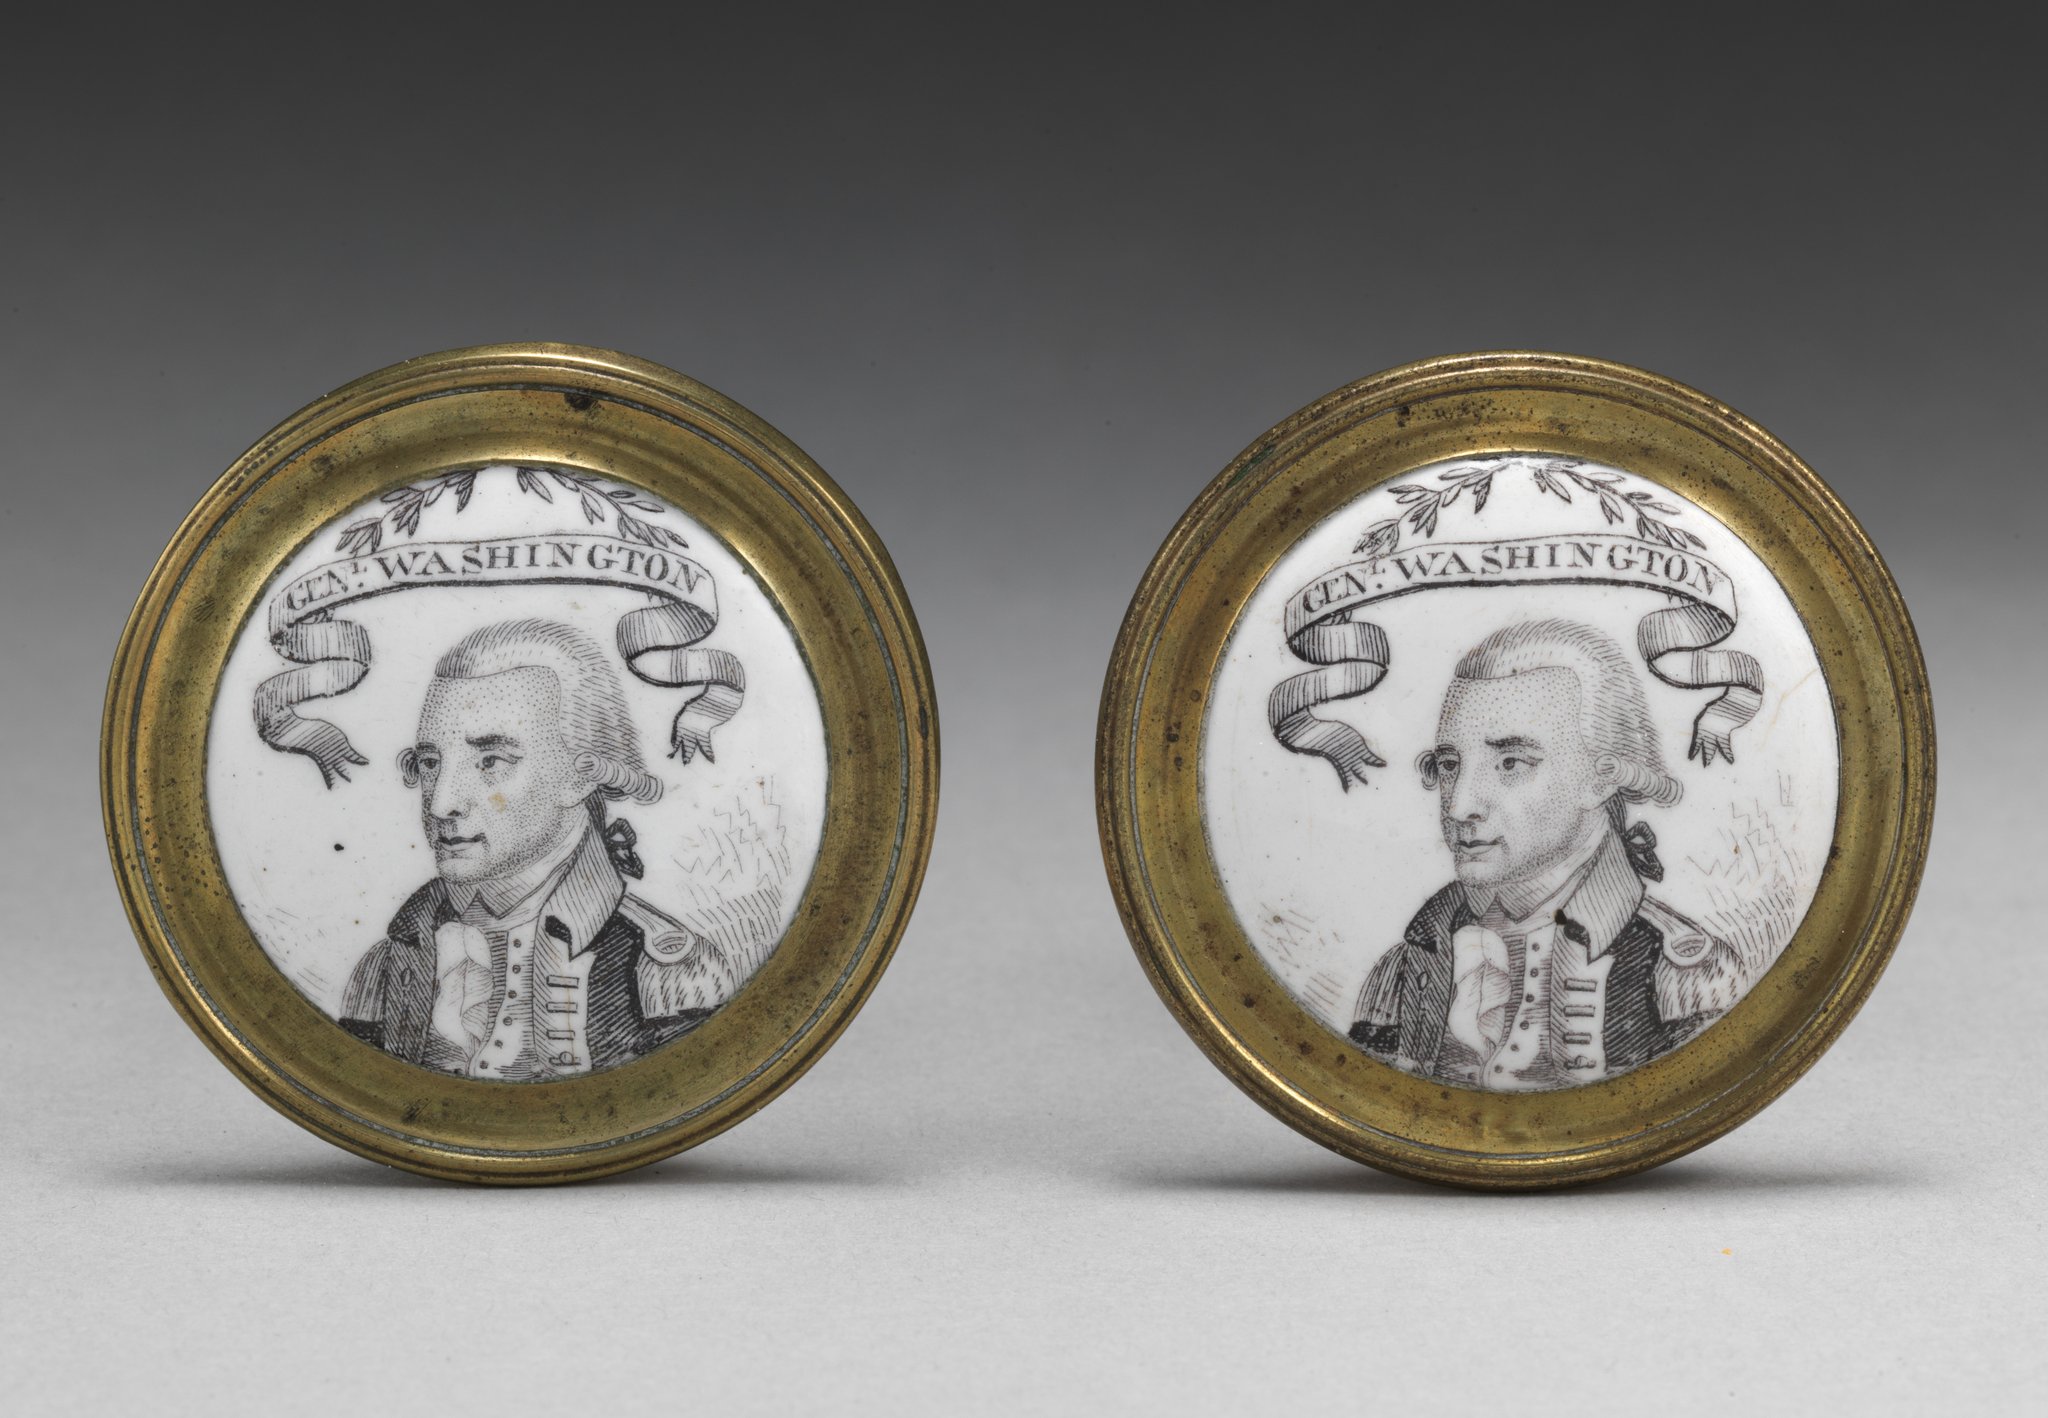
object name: knob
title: Pair of knobs depicting George Washington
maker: edward savage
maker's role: artist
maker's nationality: american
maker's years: 1761-1817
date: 1790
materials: brass, copper, enamel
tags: george washington,men,portraits